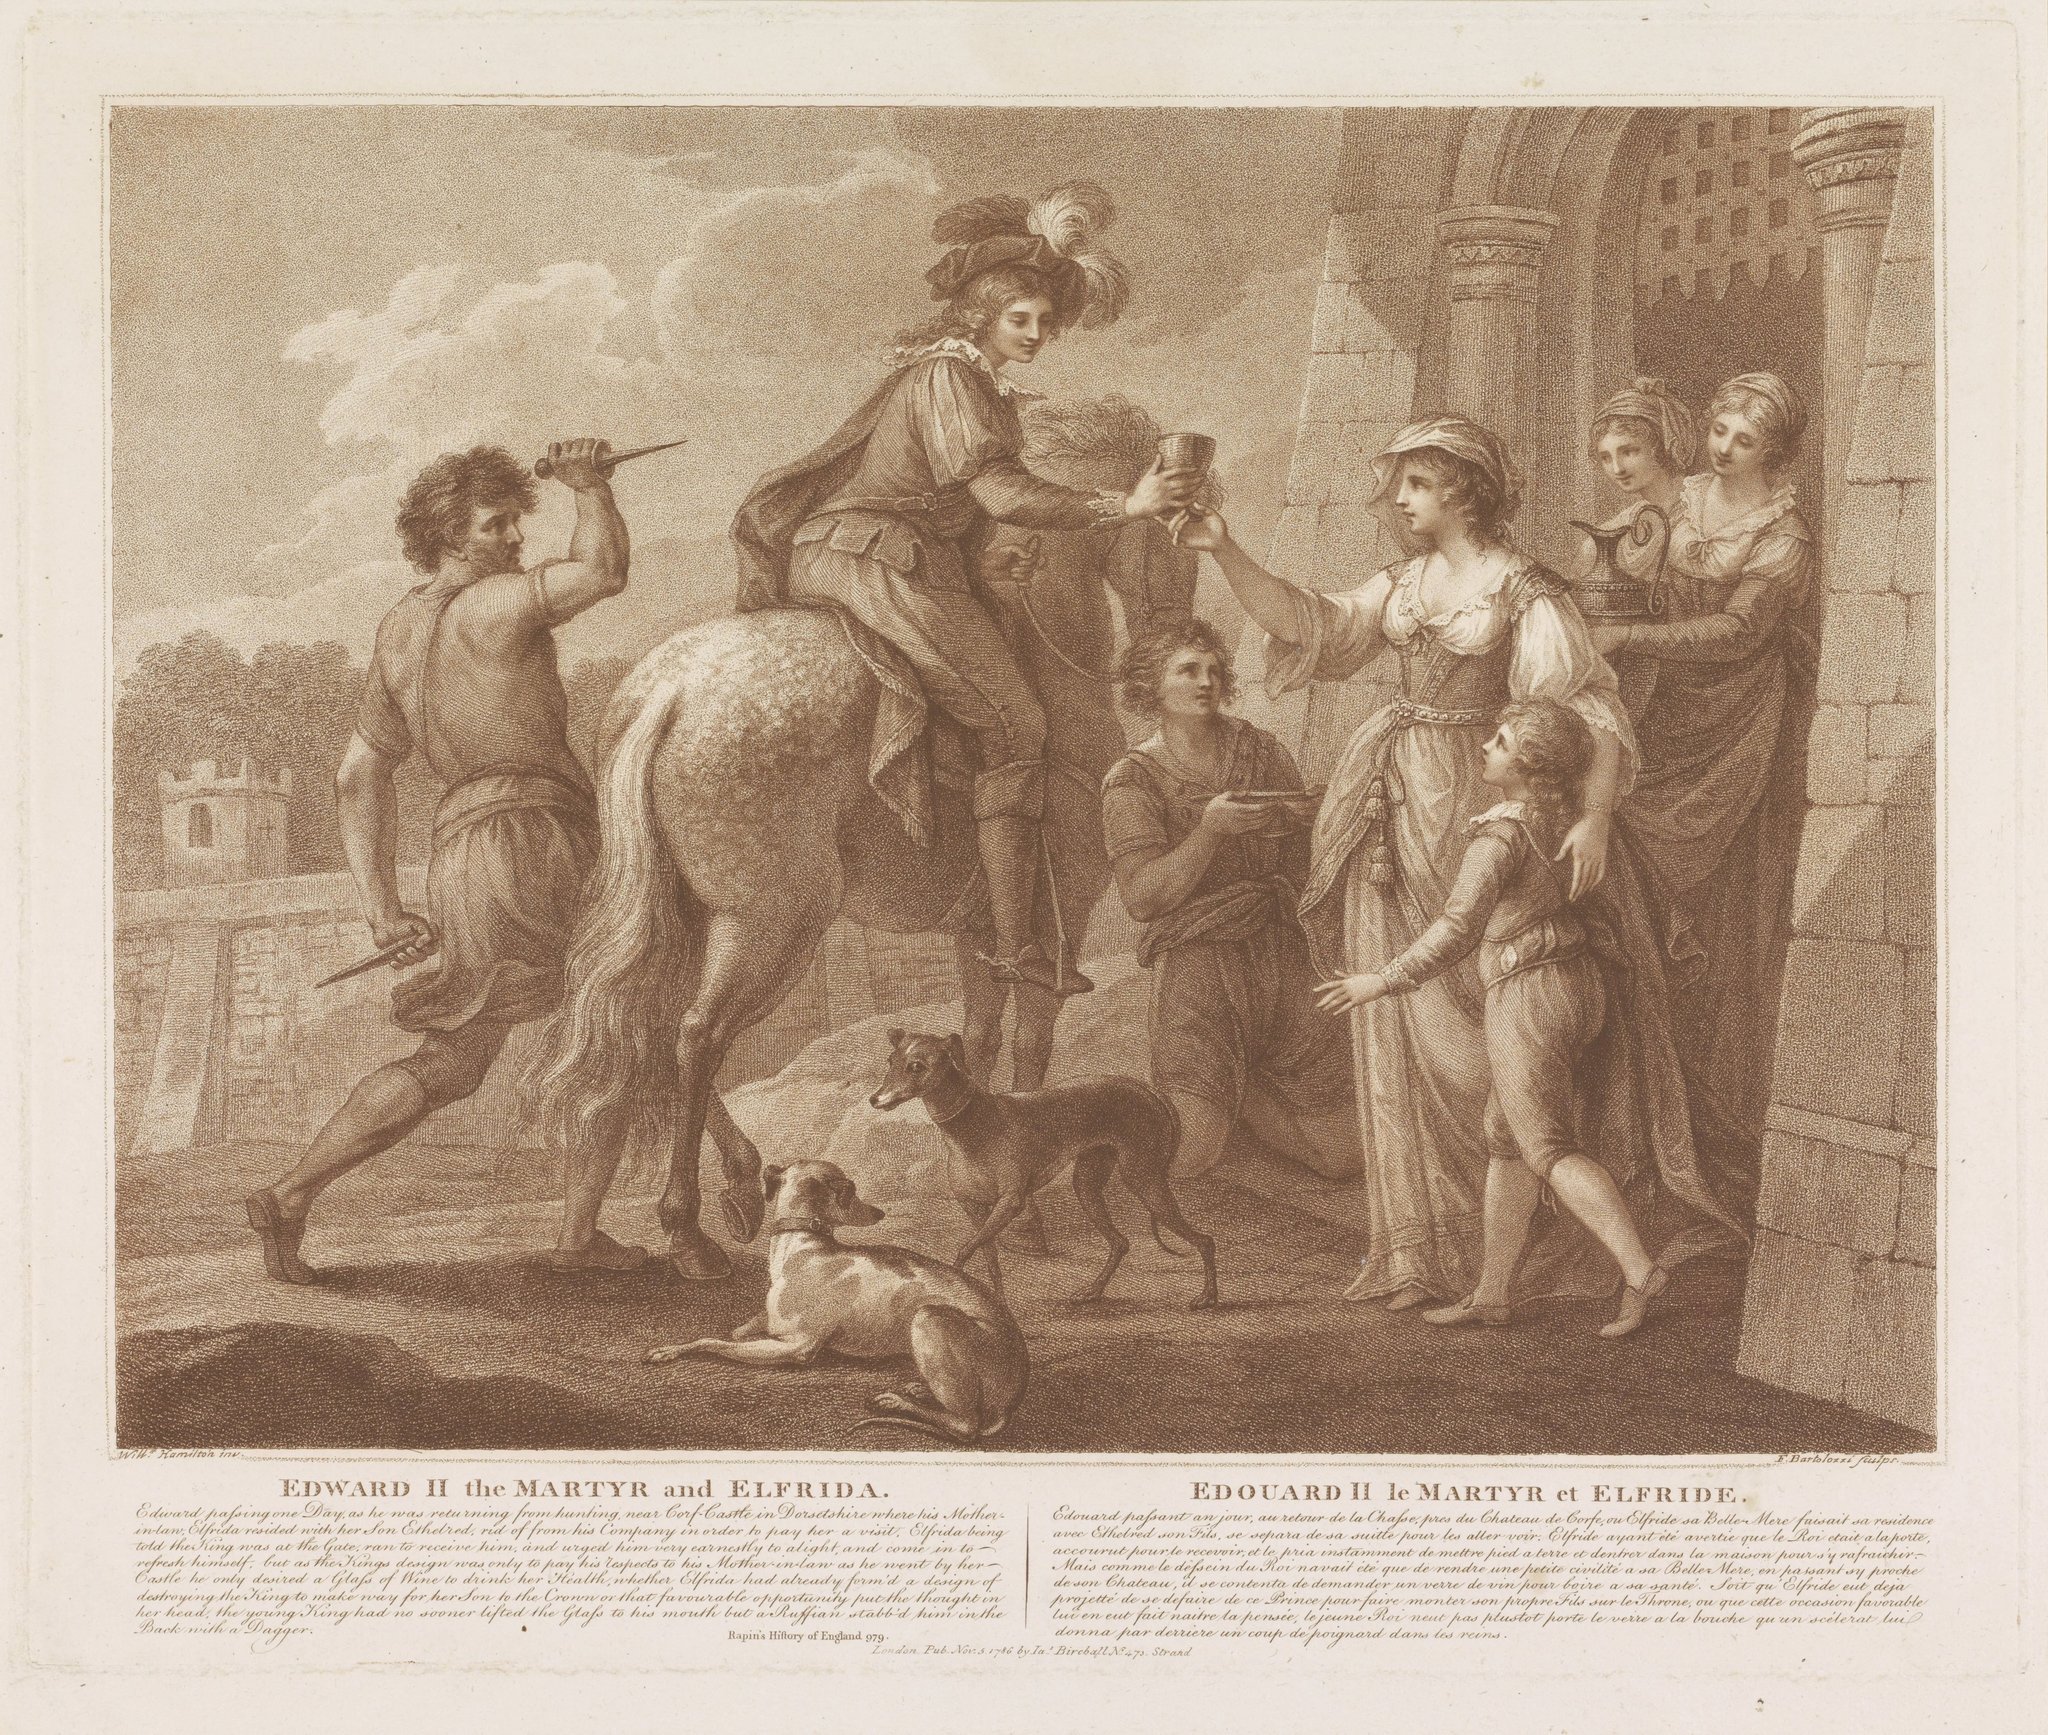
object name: print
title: Edward II de Martelaar en Elfrida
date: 1786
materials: paper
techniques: etching, engraving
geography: london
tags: historical events and situations; historical persons, murder, murderer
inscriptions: collector's mark: Lugt 2165, number: ‘No. 1459’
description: Elfrida staat met haar zoon Ethelred II en haar dienaressen bij een poort. Ze biedt Eduard II de Martelaar die te paard aan komt rijden een glas mede (drank) aan. Achter Eduard staat een man die hem in de rug wil steken met een dolk. Tekst in het Engels en het Frans in de ondermarge.